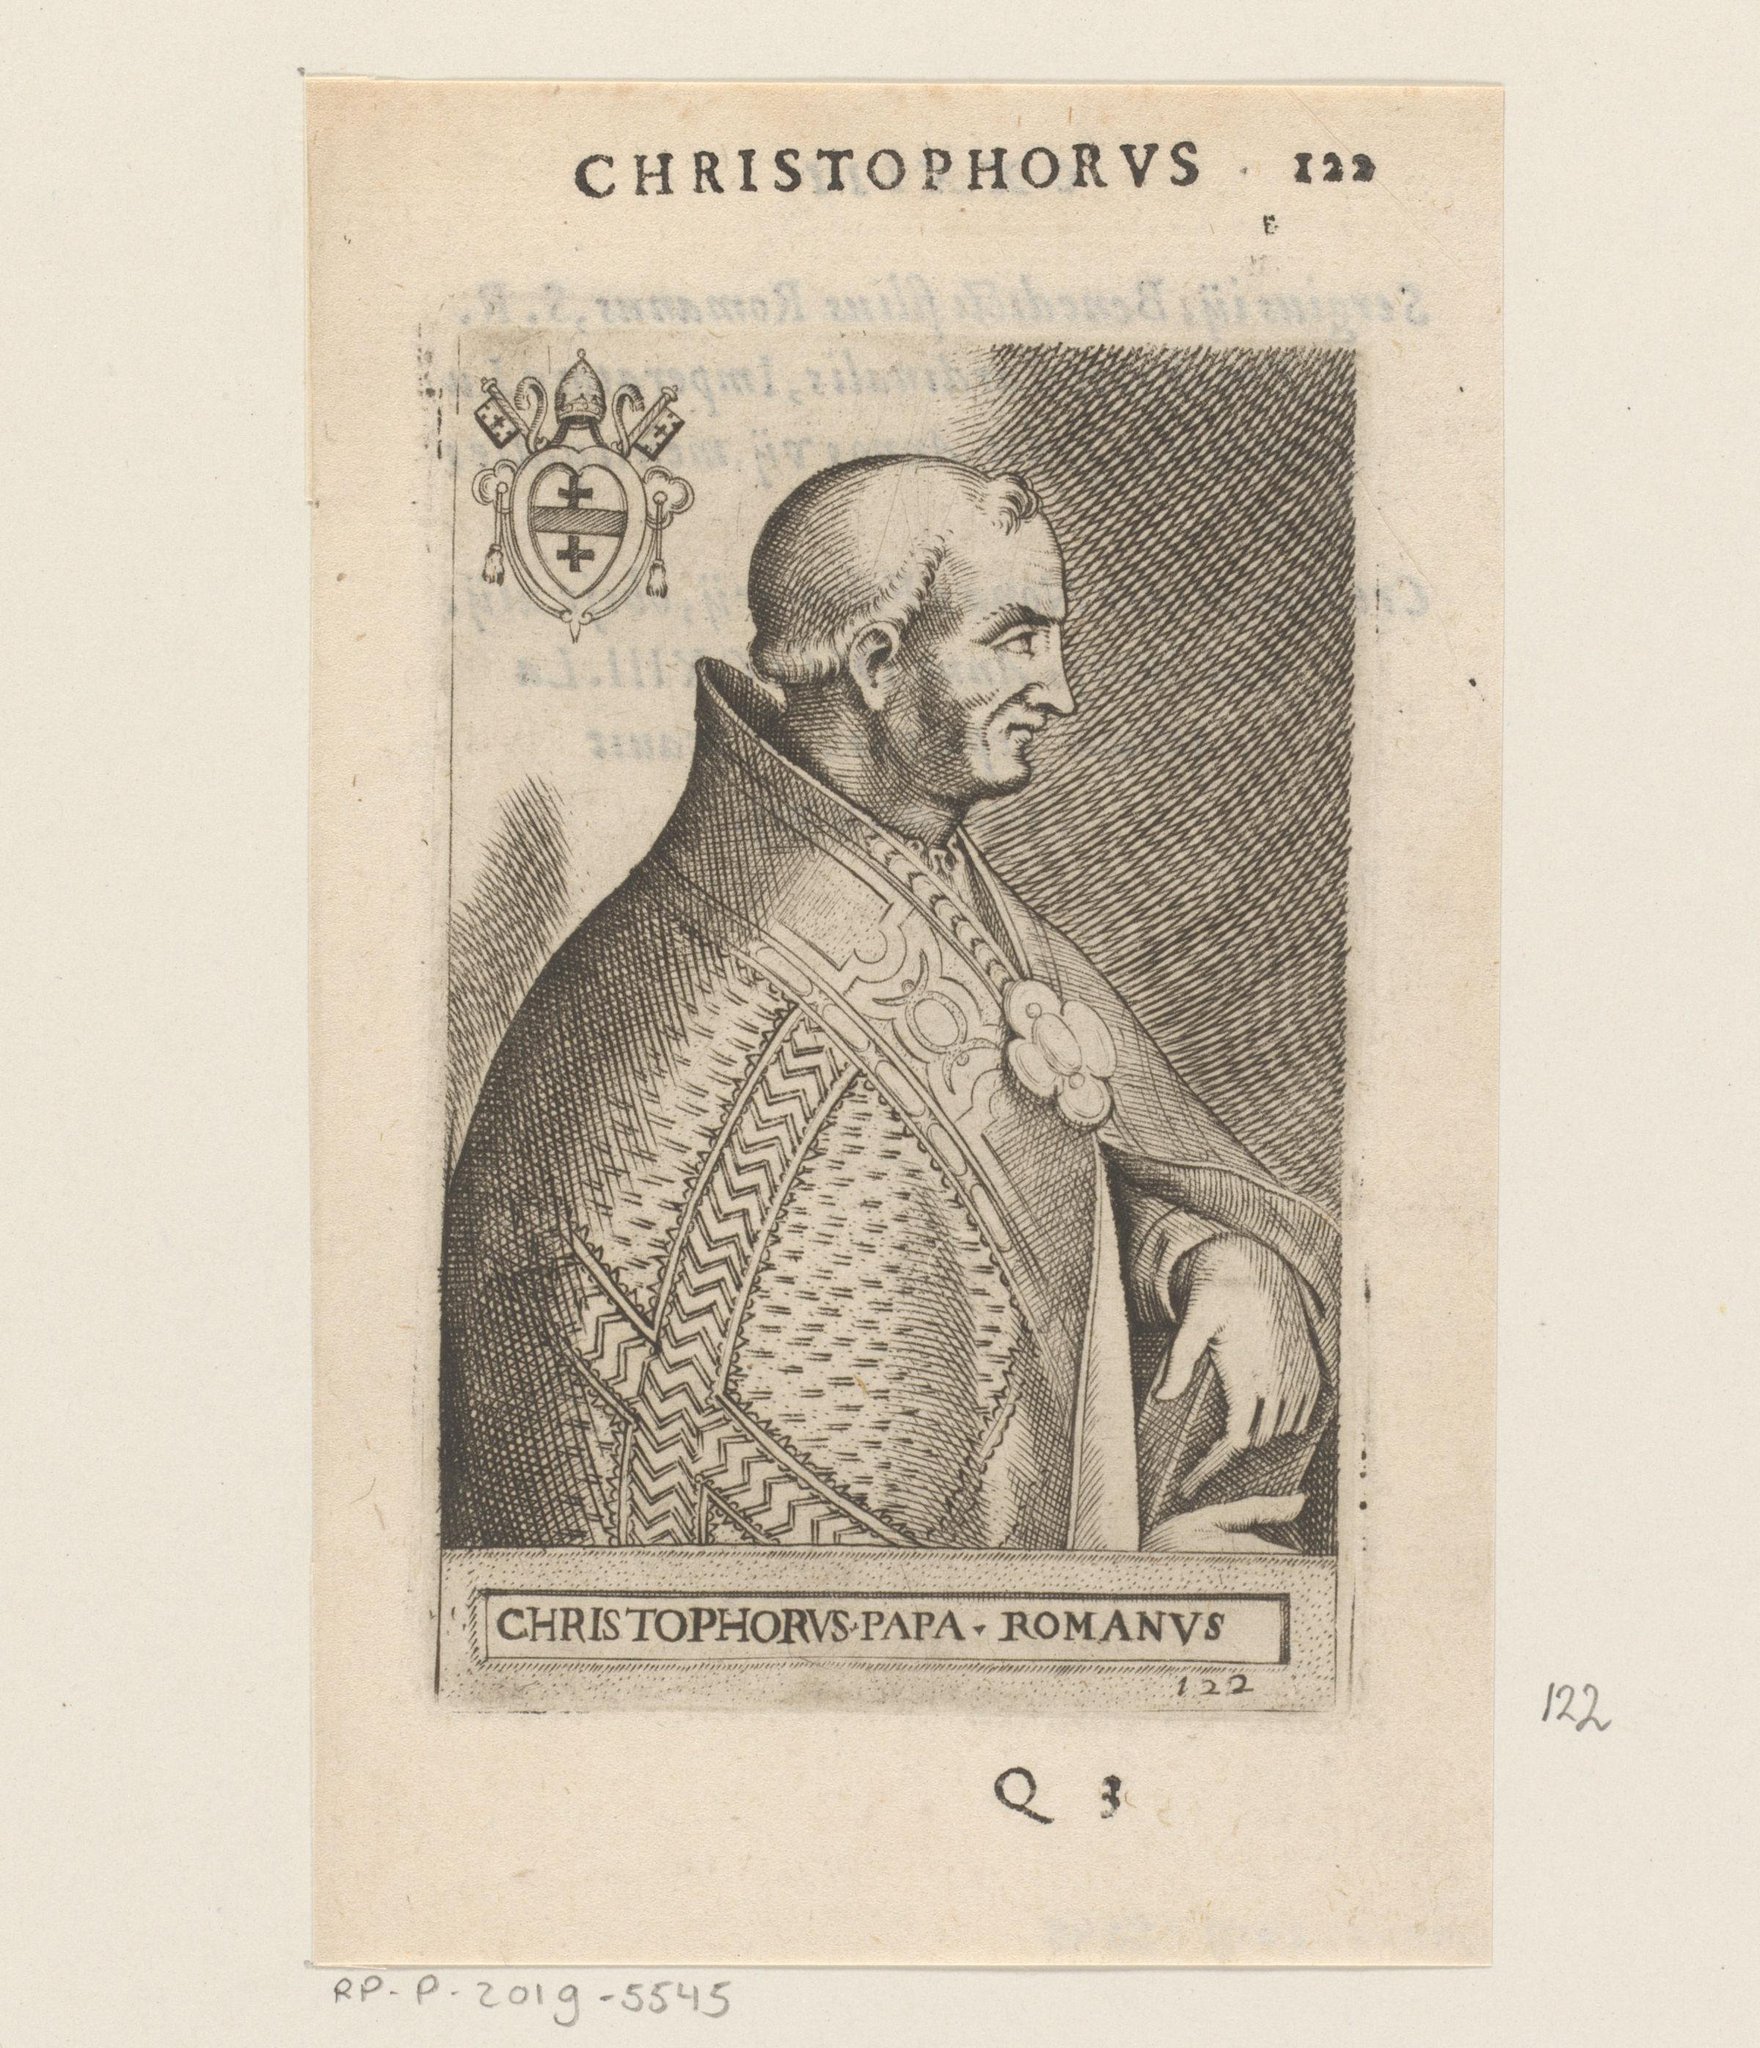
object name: book illustration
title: Portret van tegenpaus Christoforus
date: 1595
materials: paper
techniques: engraving, letterpress printing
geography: rome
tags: historical persons, pope, armorial bearing, heraldry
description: Prent uit: Cavalieri, Giovanni Battista de'. Effigies pontificum romanorum cum eorum vitis (...). Rome: Bartolomeo Bonfadino, 1595. Prent voor het eerst verschenen in: Cavalieri, Giovanni Battista de'. Pontificum romanorum effigies (...). Rome: Domenico Basa en Francesco Zanetti, 1580. Prent ook gebruikt in latere publicaties.